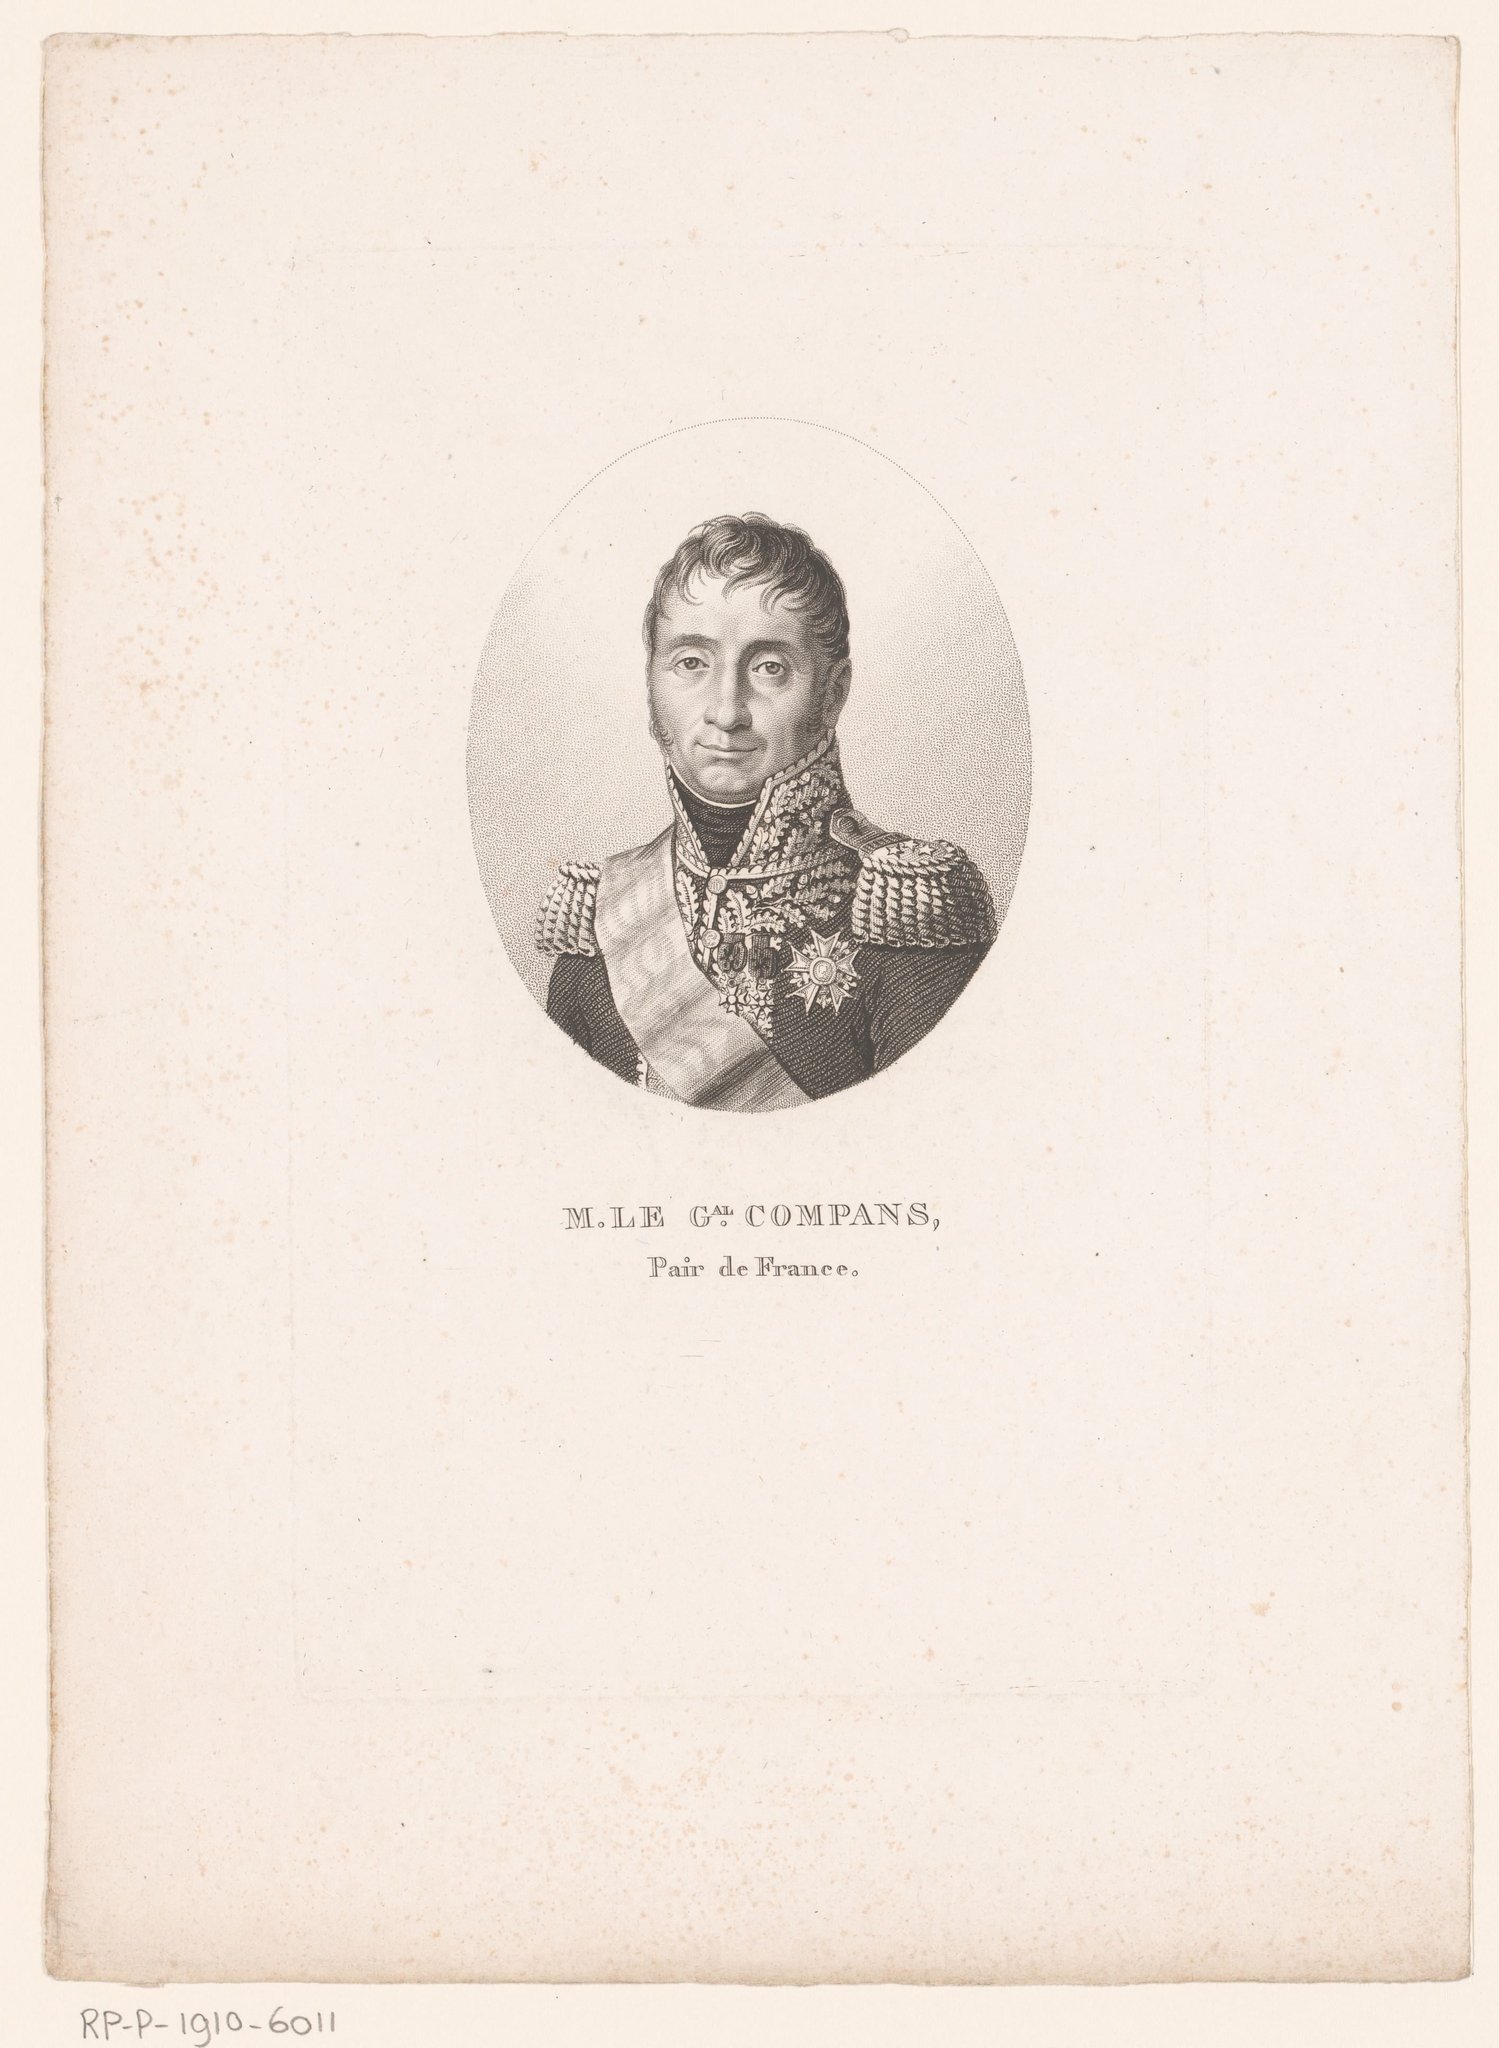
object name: print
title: Portret van Jean Dominique Compans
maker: ambroise tardieu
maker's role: print maker, printer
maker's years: 1788-1841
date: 1820-1821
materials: paper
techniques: engraving, roulette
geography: paris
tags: ranks in the army, historical persons, politician, e.g. party leader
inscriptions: collector's mark: Lugt 2228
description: Prent uit: Tardieu, Ambroise. Portraits des députés, écrivains et pairs constitutionnels, défenseurs invariables de la charte et de la loi des élections du 5 février 1817. Parijs: Tardieu, Ambroise, 1820-1821.